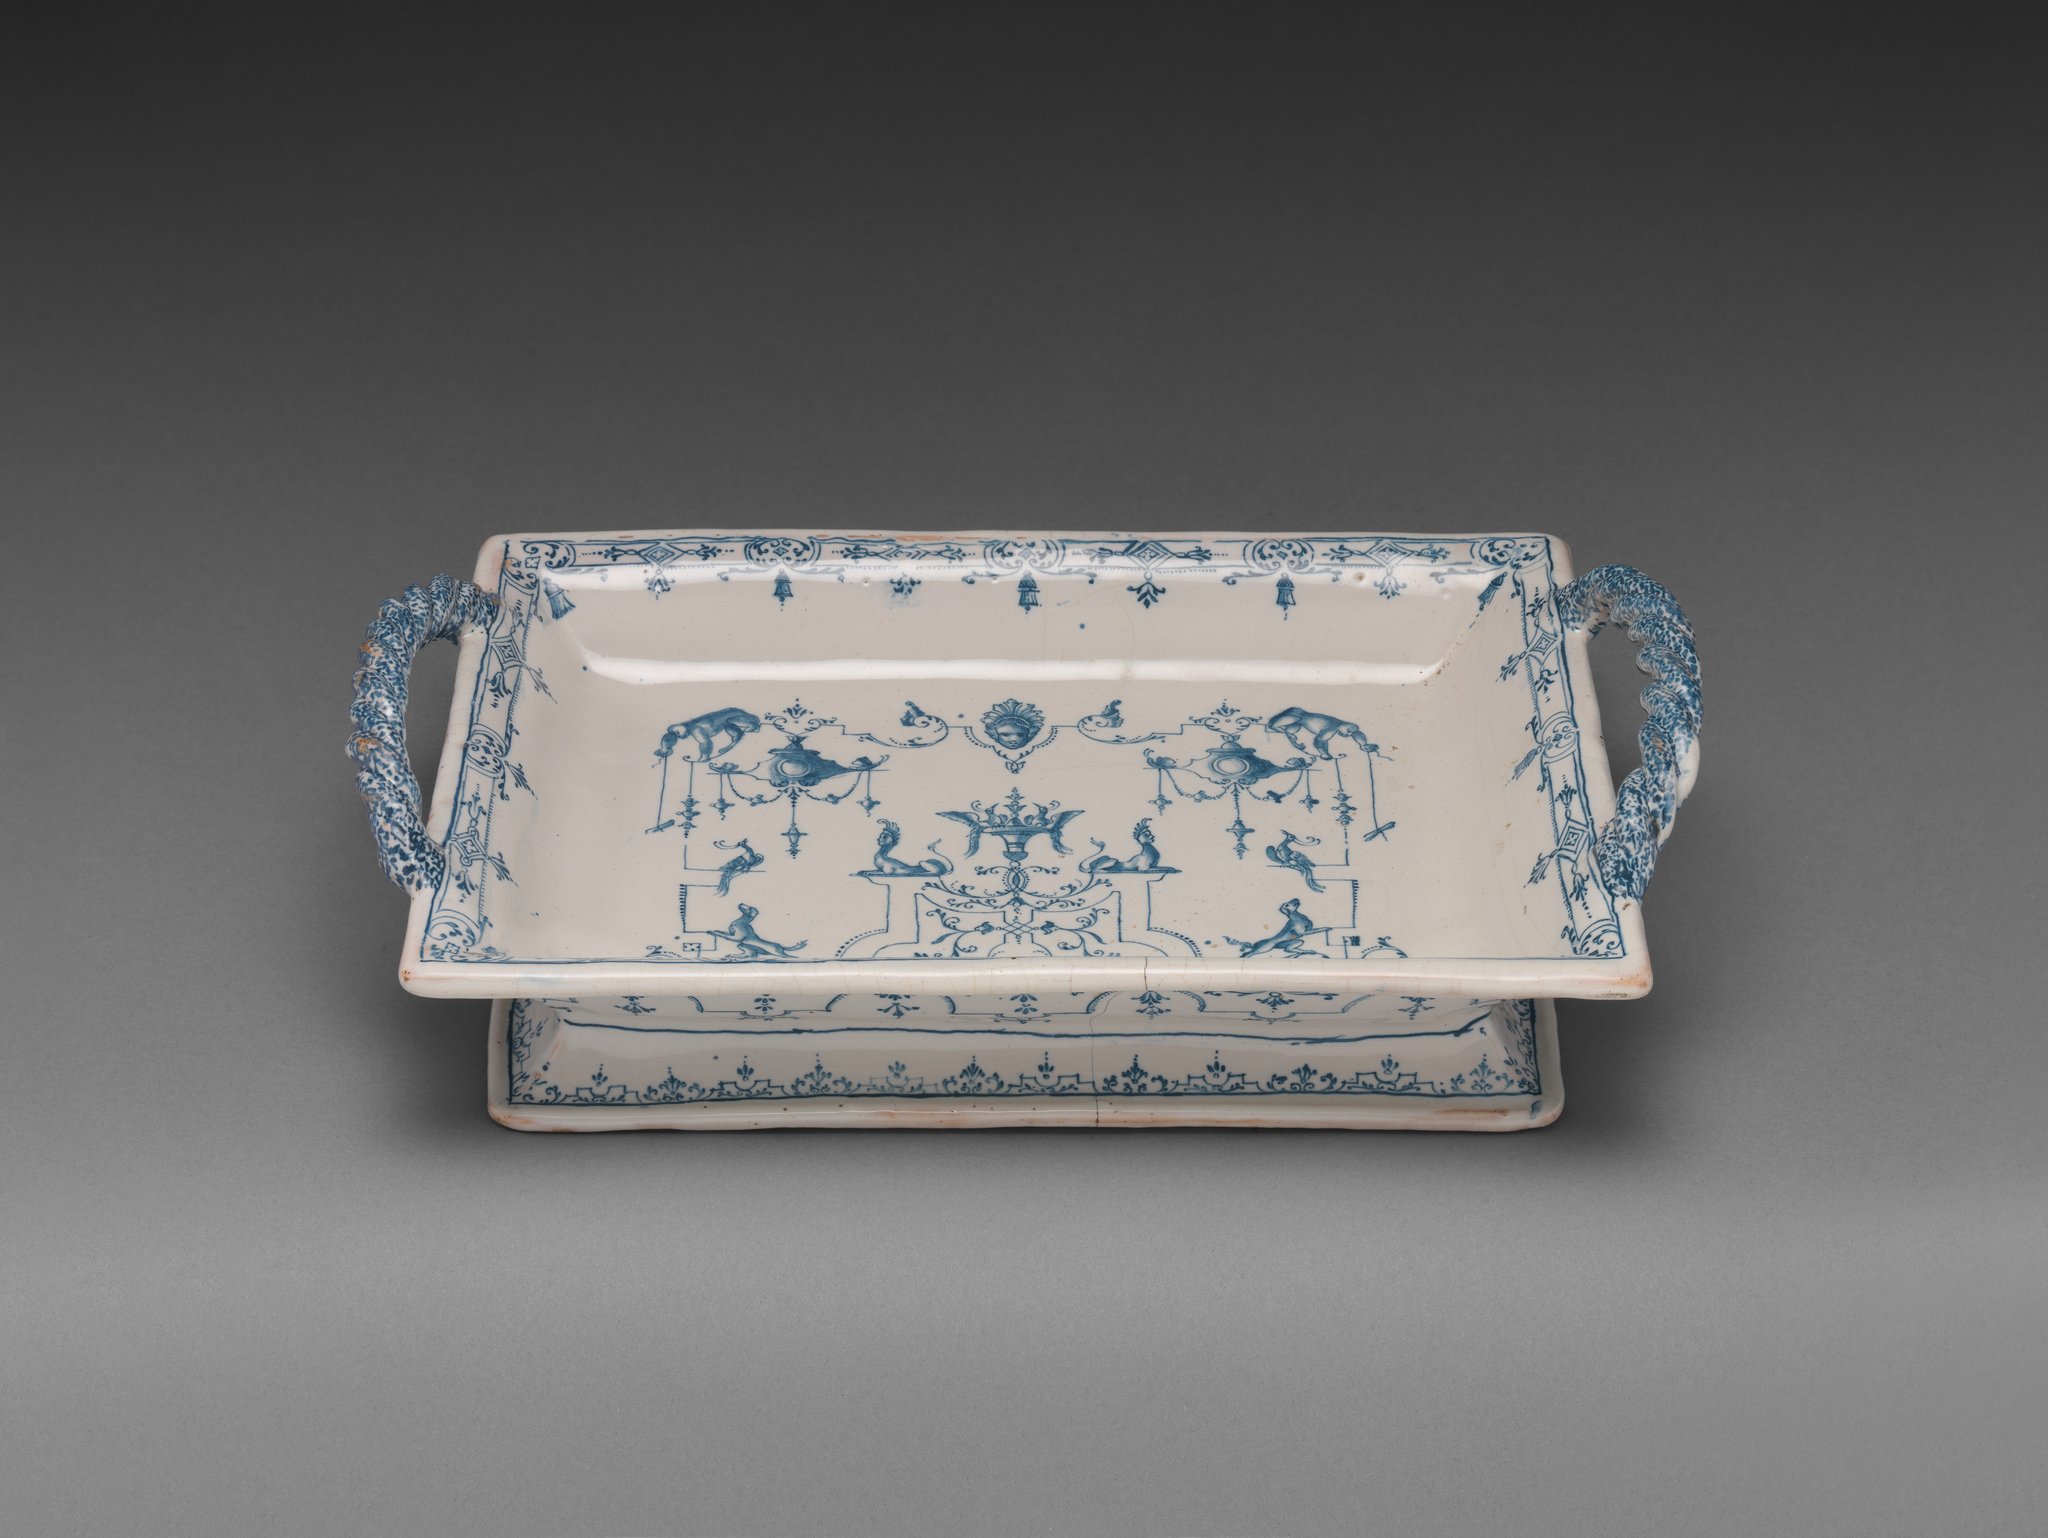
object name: dish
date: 1725-1735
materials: faience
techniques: glazing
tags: birds,faces,sphinx,peacocks,dogs,monkeys